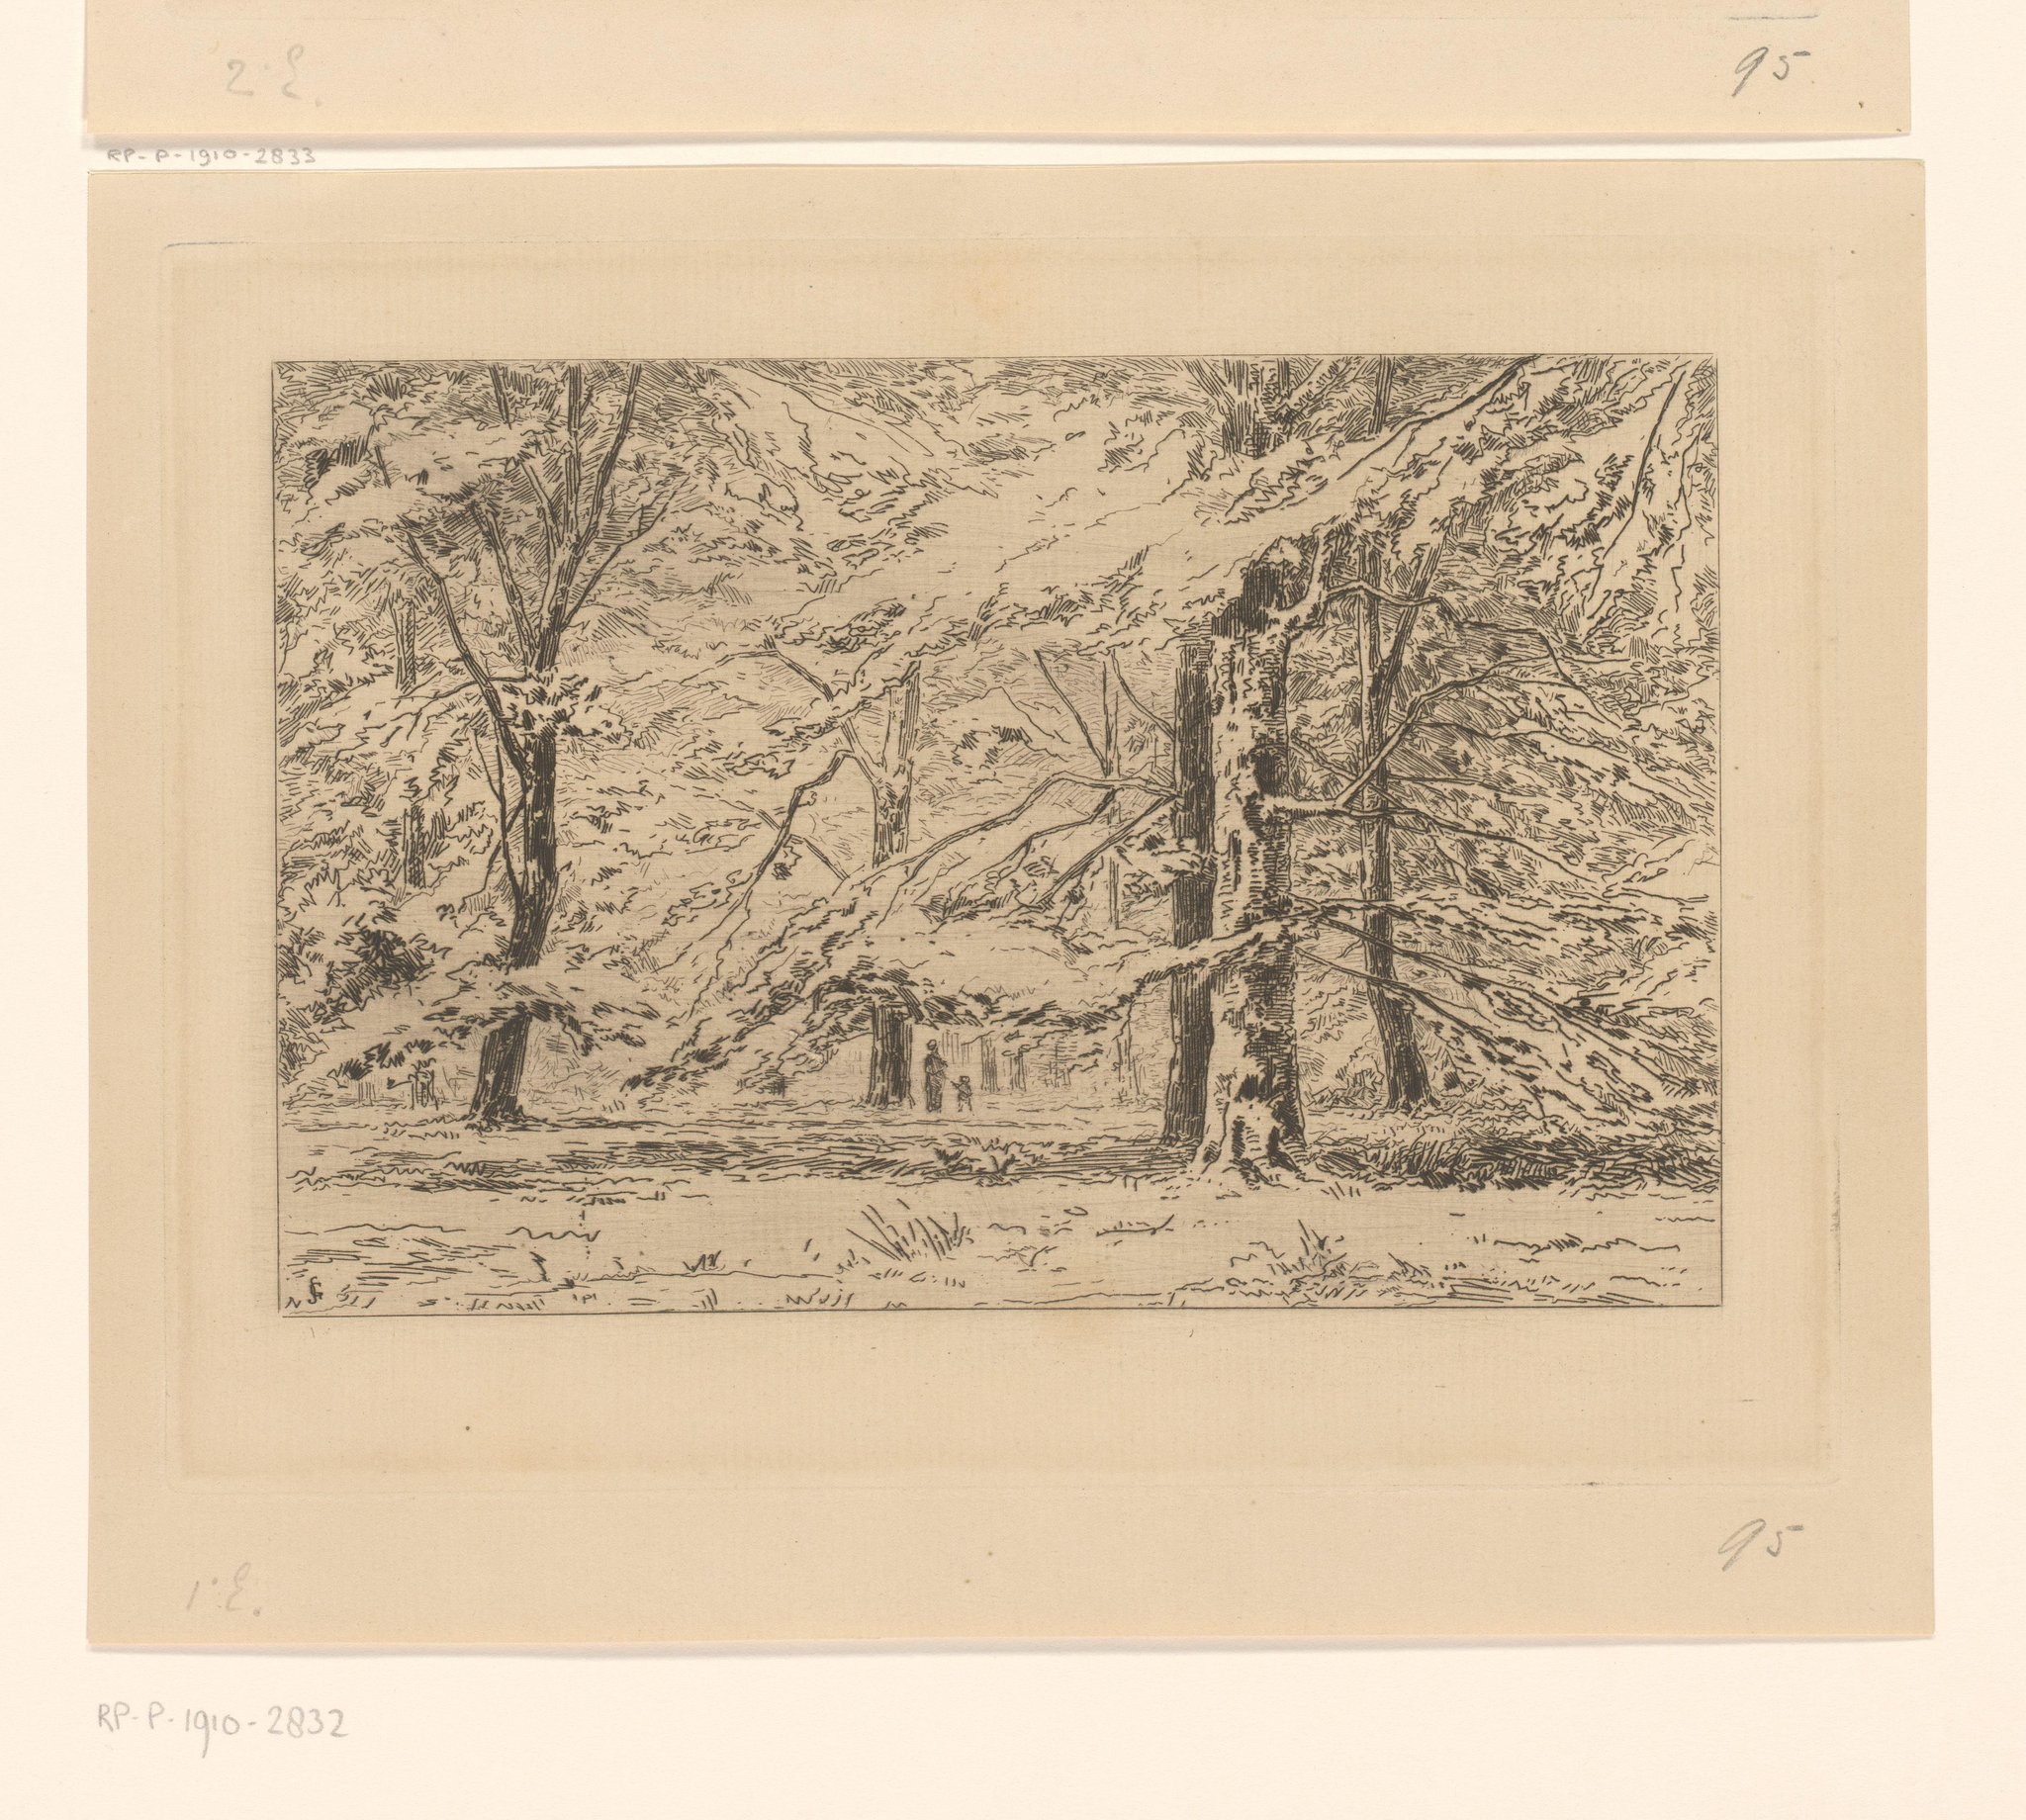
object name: print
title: La Hollande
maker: carel nicolaas storm van s-gravesande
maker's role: draughtsman, print maker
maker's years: 1841-1924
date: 1877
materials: paper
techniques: etching, intaglio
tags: forest, wood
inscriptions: collector's mark: Lugt 2228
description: In het midden staat een figuur met een kind naast een boom.